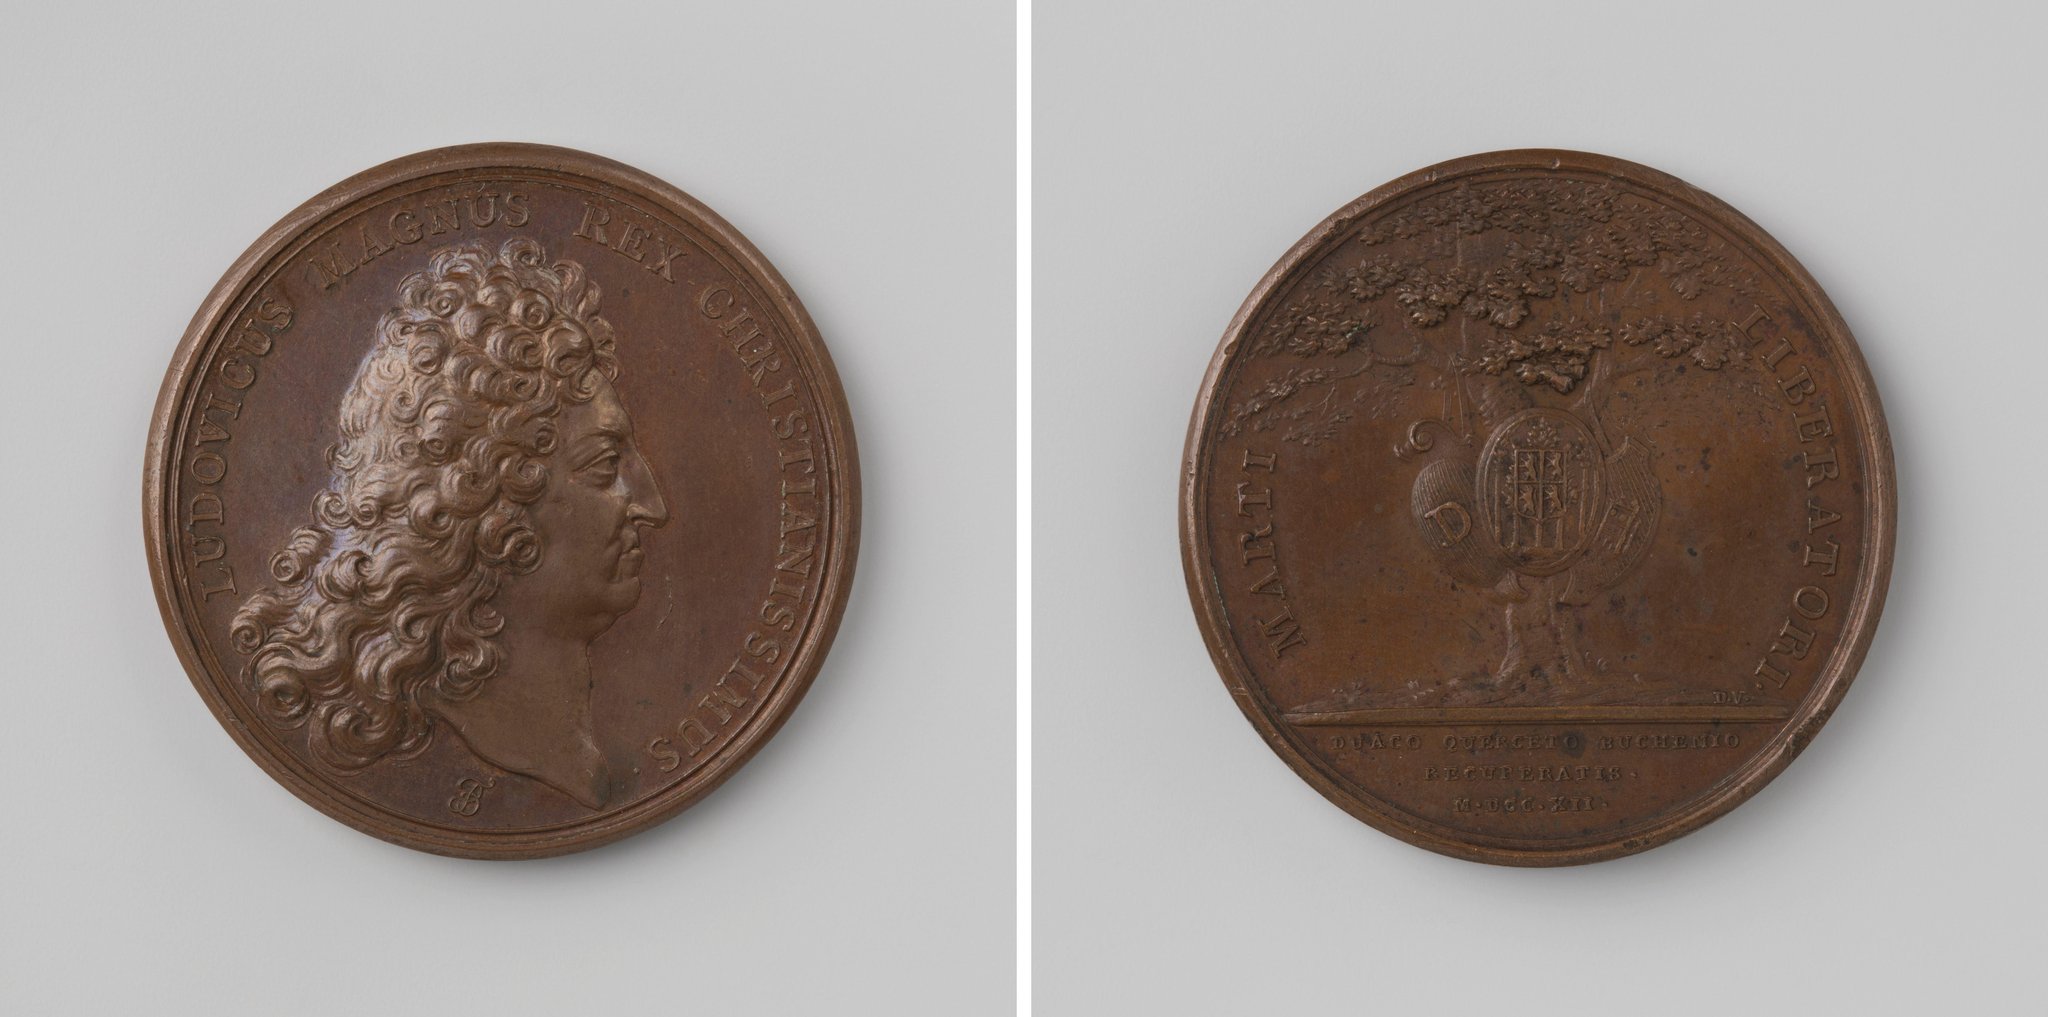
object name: history medal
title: Verovering van Douai, Quesnoy en Bouchain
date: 1712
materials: bronze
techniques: striking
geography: paris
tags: lodewijk xiv (koning van frankrijk)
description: Bronzen penning. Voorzijde: borststuk man binnen omschrift. Keerzijde: drie wapenschilden, hangend in een boom binnen omschrift; afsnede: opschrift